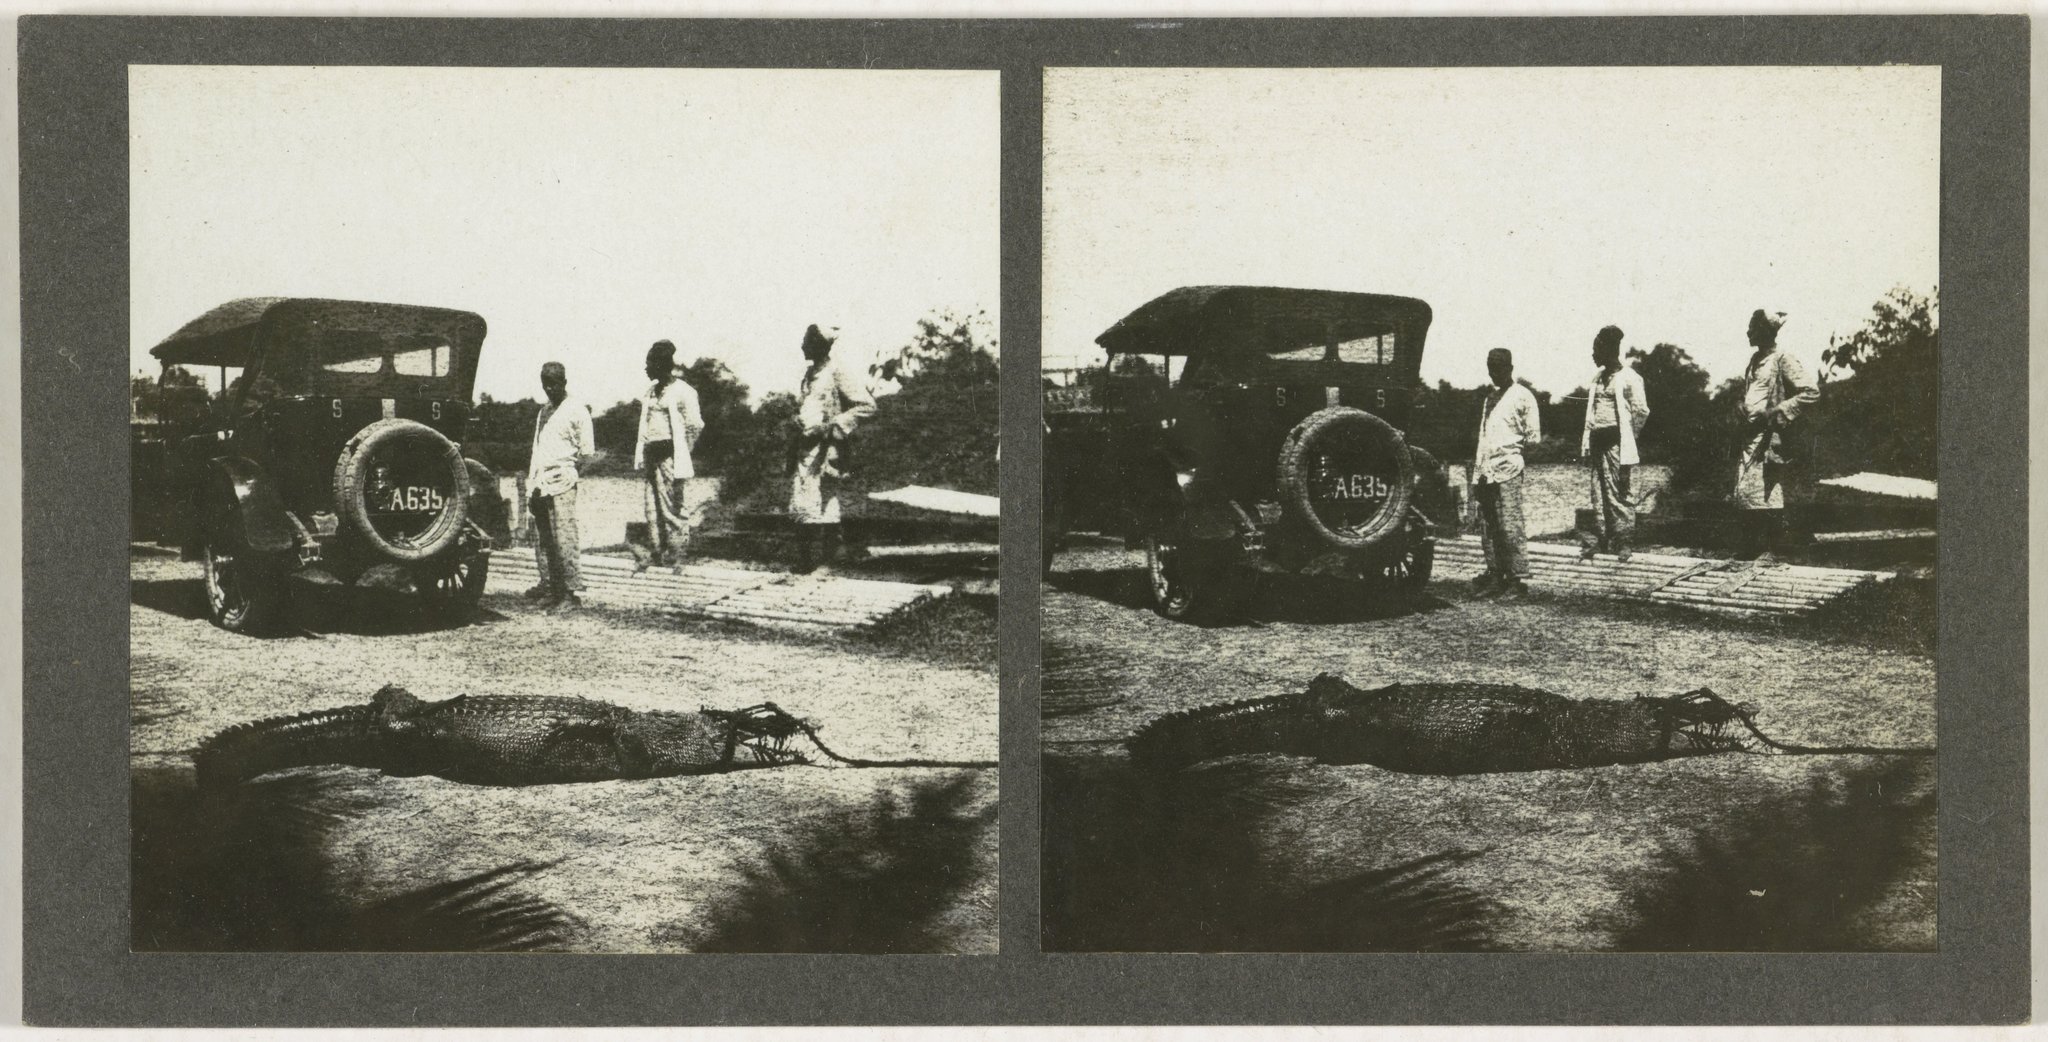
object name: stereograph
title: Gevangen kaaiman nabij Kerinci, Indonesië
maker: Anonymous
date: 1900-1940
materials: paper, cardboard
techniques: gelatin silver print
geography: kerinci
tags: crocodiles: alligator, indonesia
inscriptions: inscription: ‘S. Westkust. Op weg naar/ Indrapoera. Gevangen kaaiman.’